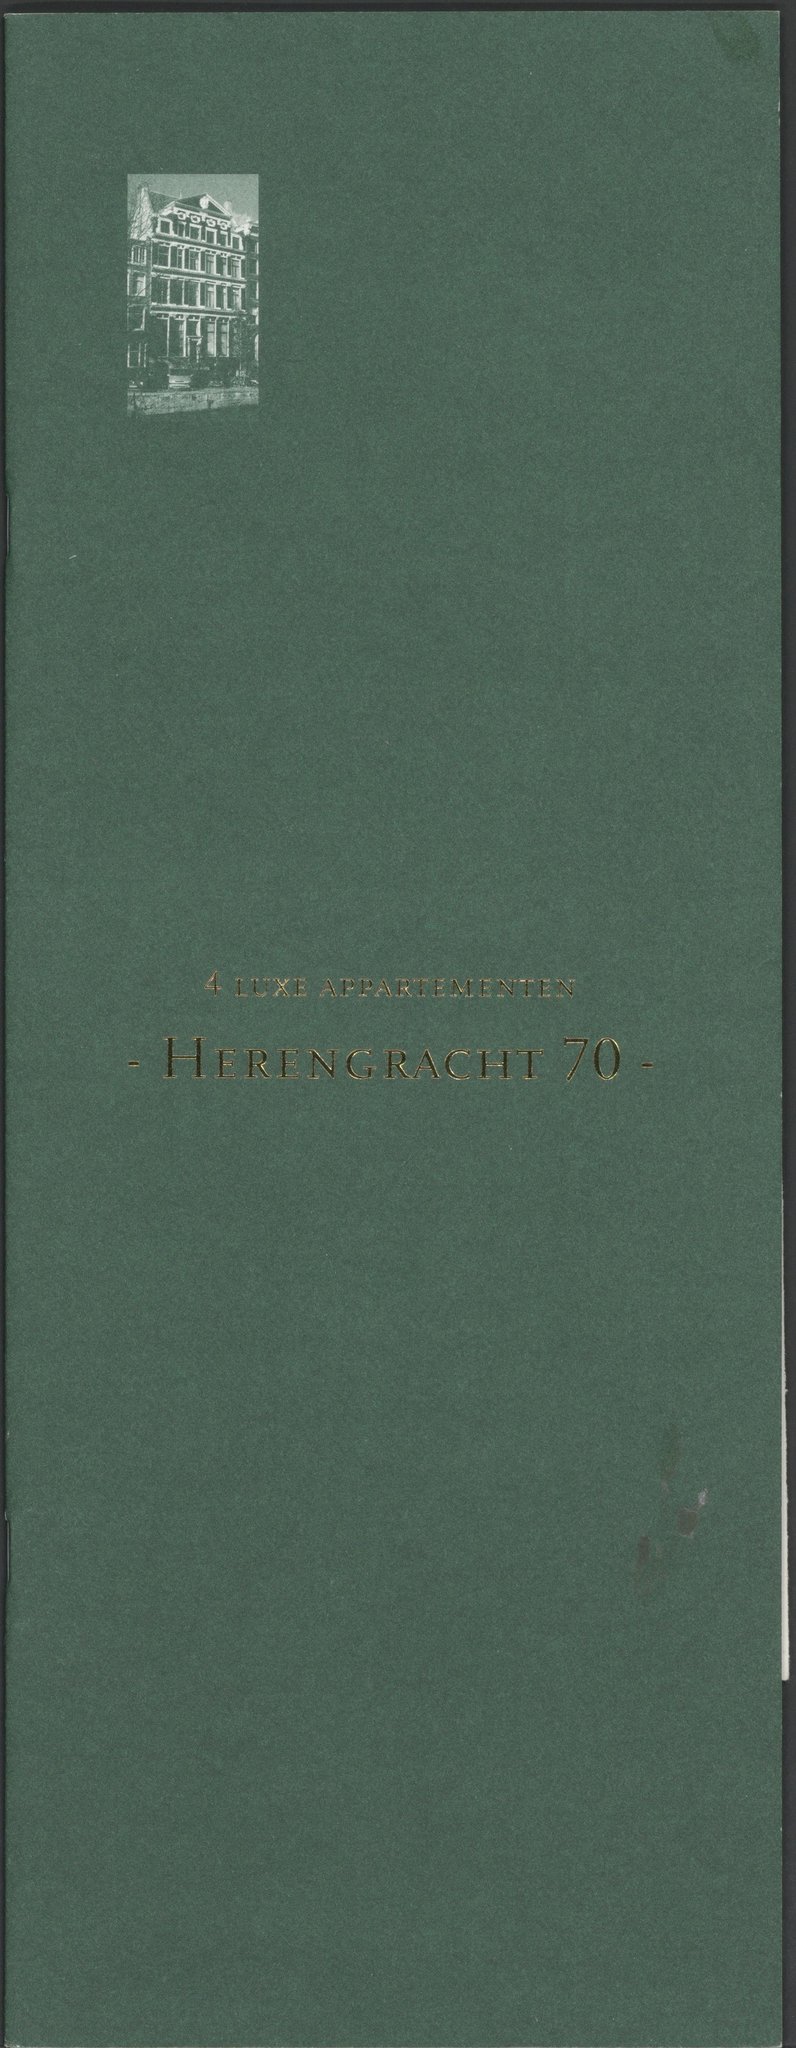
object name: brochure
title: 4 Luxe Appartementen - Herengracht 70 -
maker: Anonymous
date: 1903-1999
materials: cardboard, metal, paper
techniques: letterpress printing, offset printed, stapling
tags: flat-building, apartment house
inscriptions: inscription: ‘Atlas A'dam / Port. 6 omslag 8C / Heerengracht / zie ook Keizersgracht 107’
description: Onderwerpsrubriek binnen de Atlas Amsterdam: Haarlemmerplein, Halvemaansteeg, Handboogstraat, Handelskade, Haringpakkerij, Hartenstraat, Hasseltsteeg (Dirk van), Heerengracht.